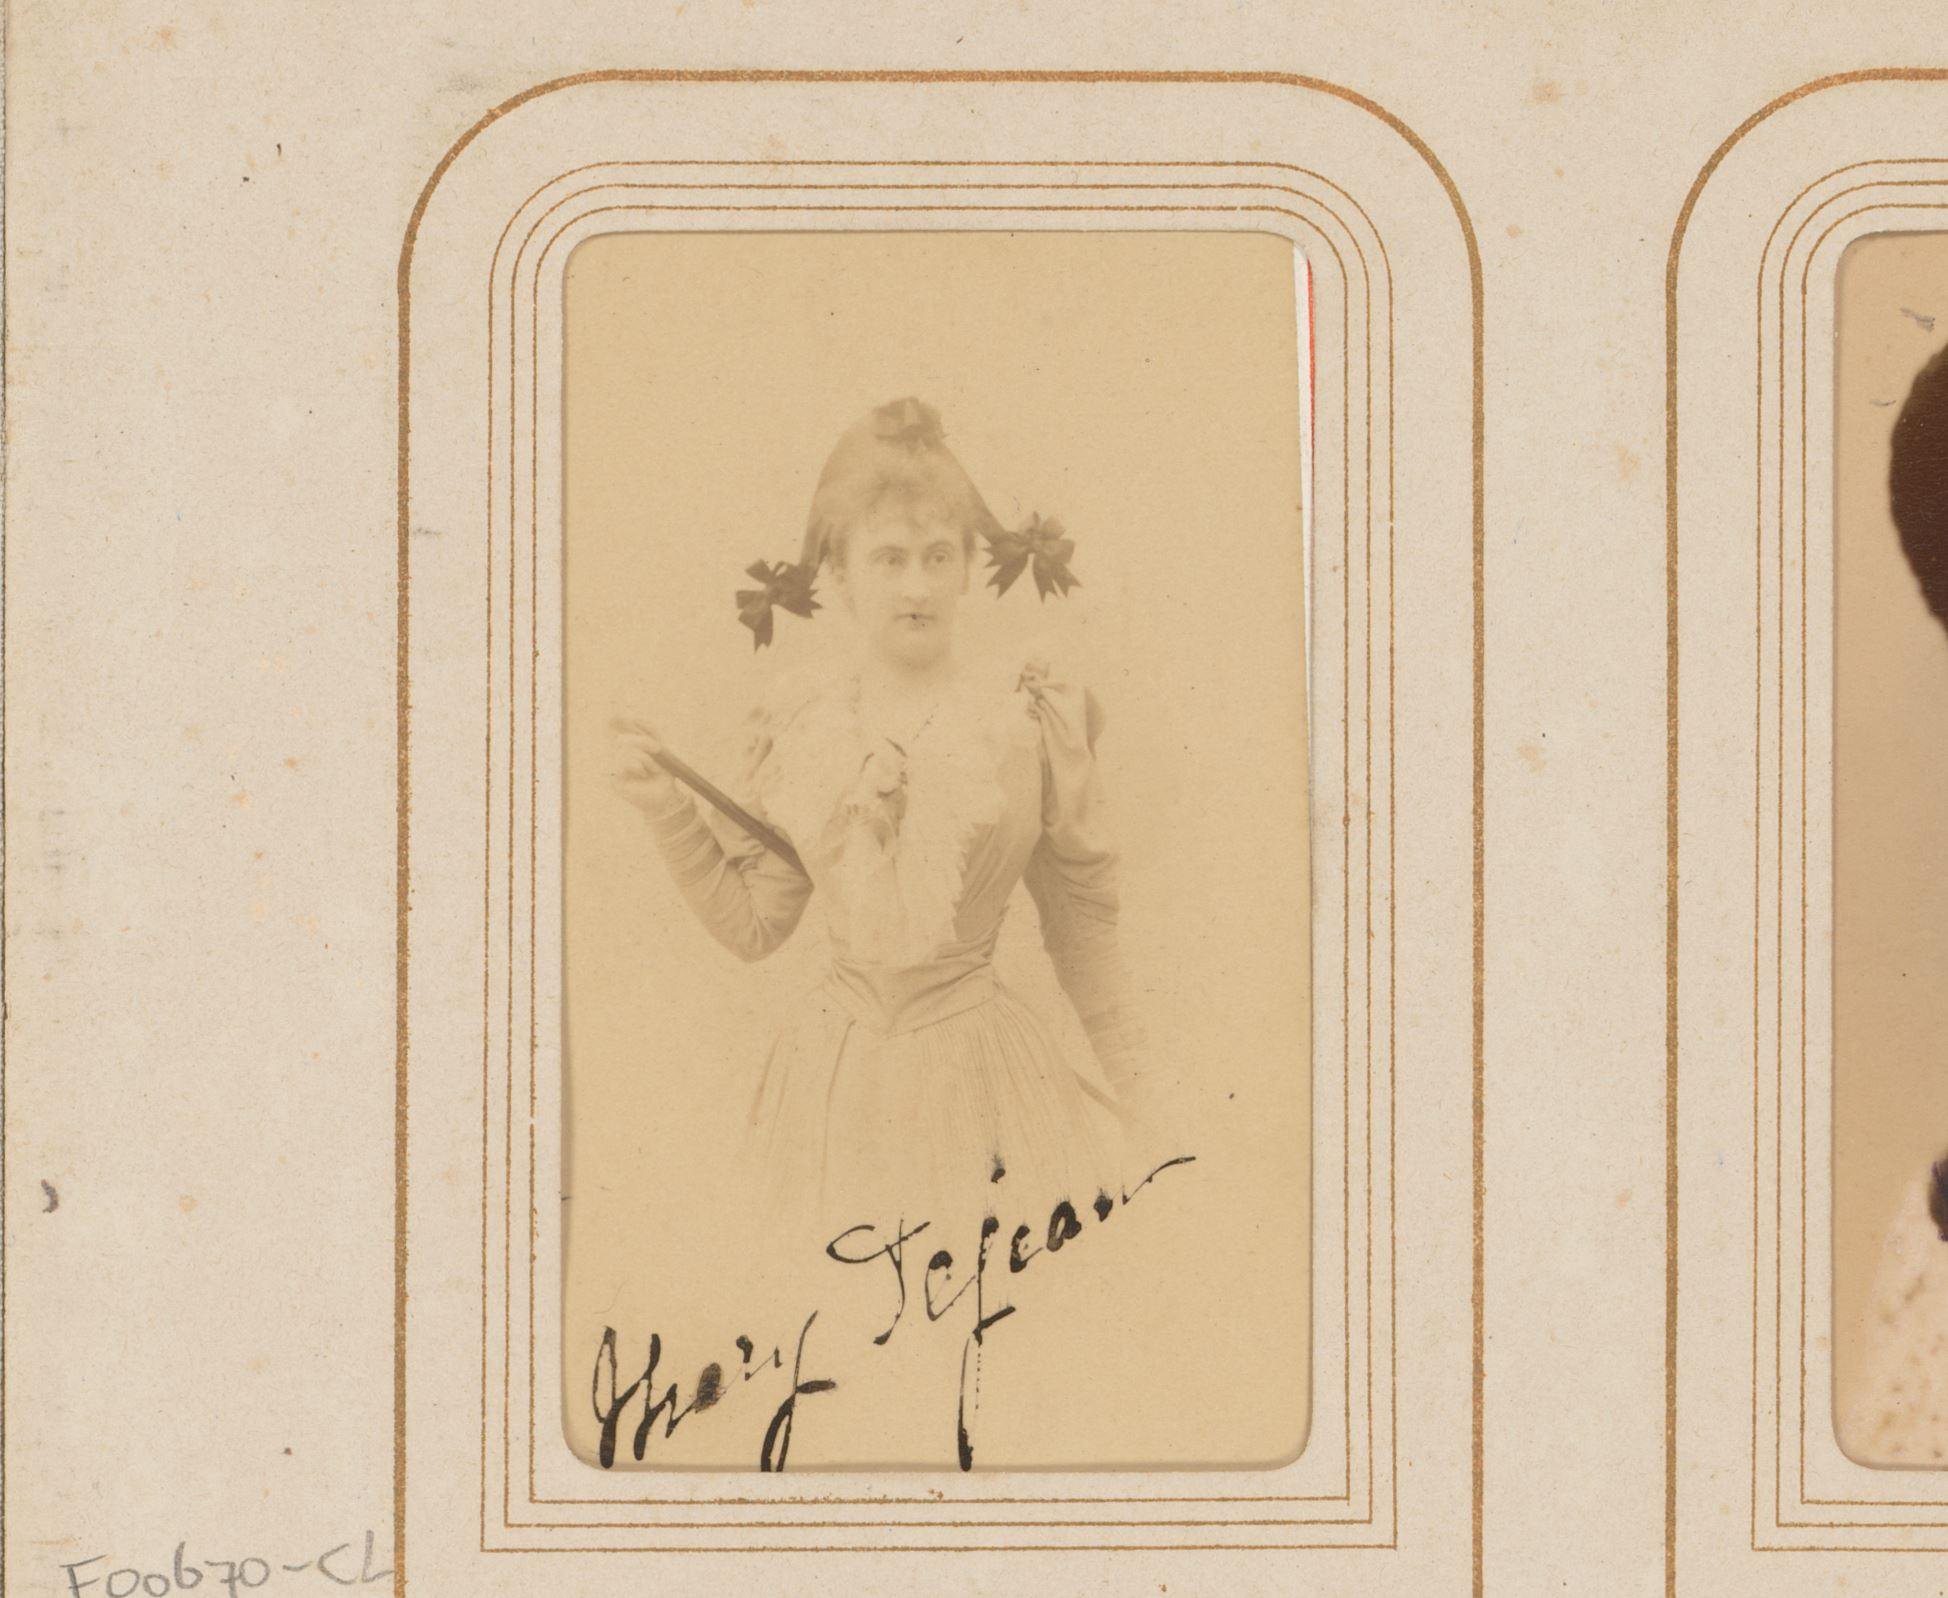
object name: carte de visite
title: Portret van een vrouw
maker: Anonymous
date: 1890-1900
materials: cardboard, photographic support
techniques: albumen print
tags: historical persons - bb - woman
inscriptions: annotation: ‘[Shary Dejeanne]’